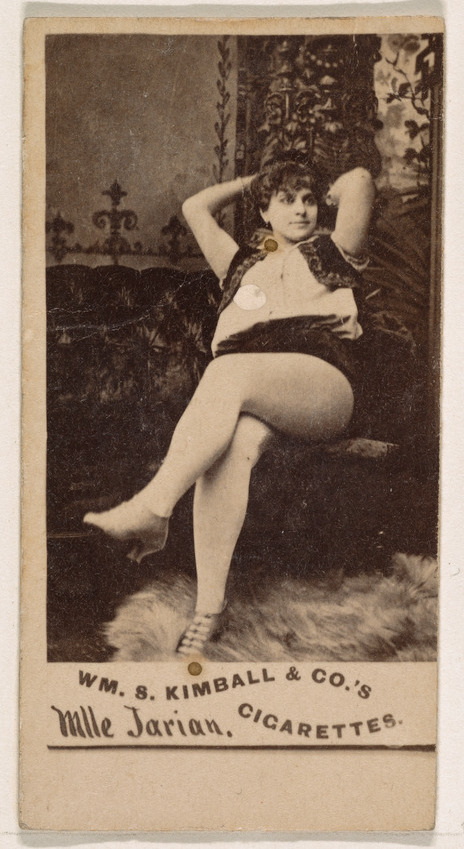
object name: photograph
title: Mlle. Jarian, from the Actresses series (N203) issued by Wm. S. Kimball & Co.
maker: william s. kimball & company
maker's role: publisher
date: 1889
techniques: color lithograph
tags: portraits,women,actresses